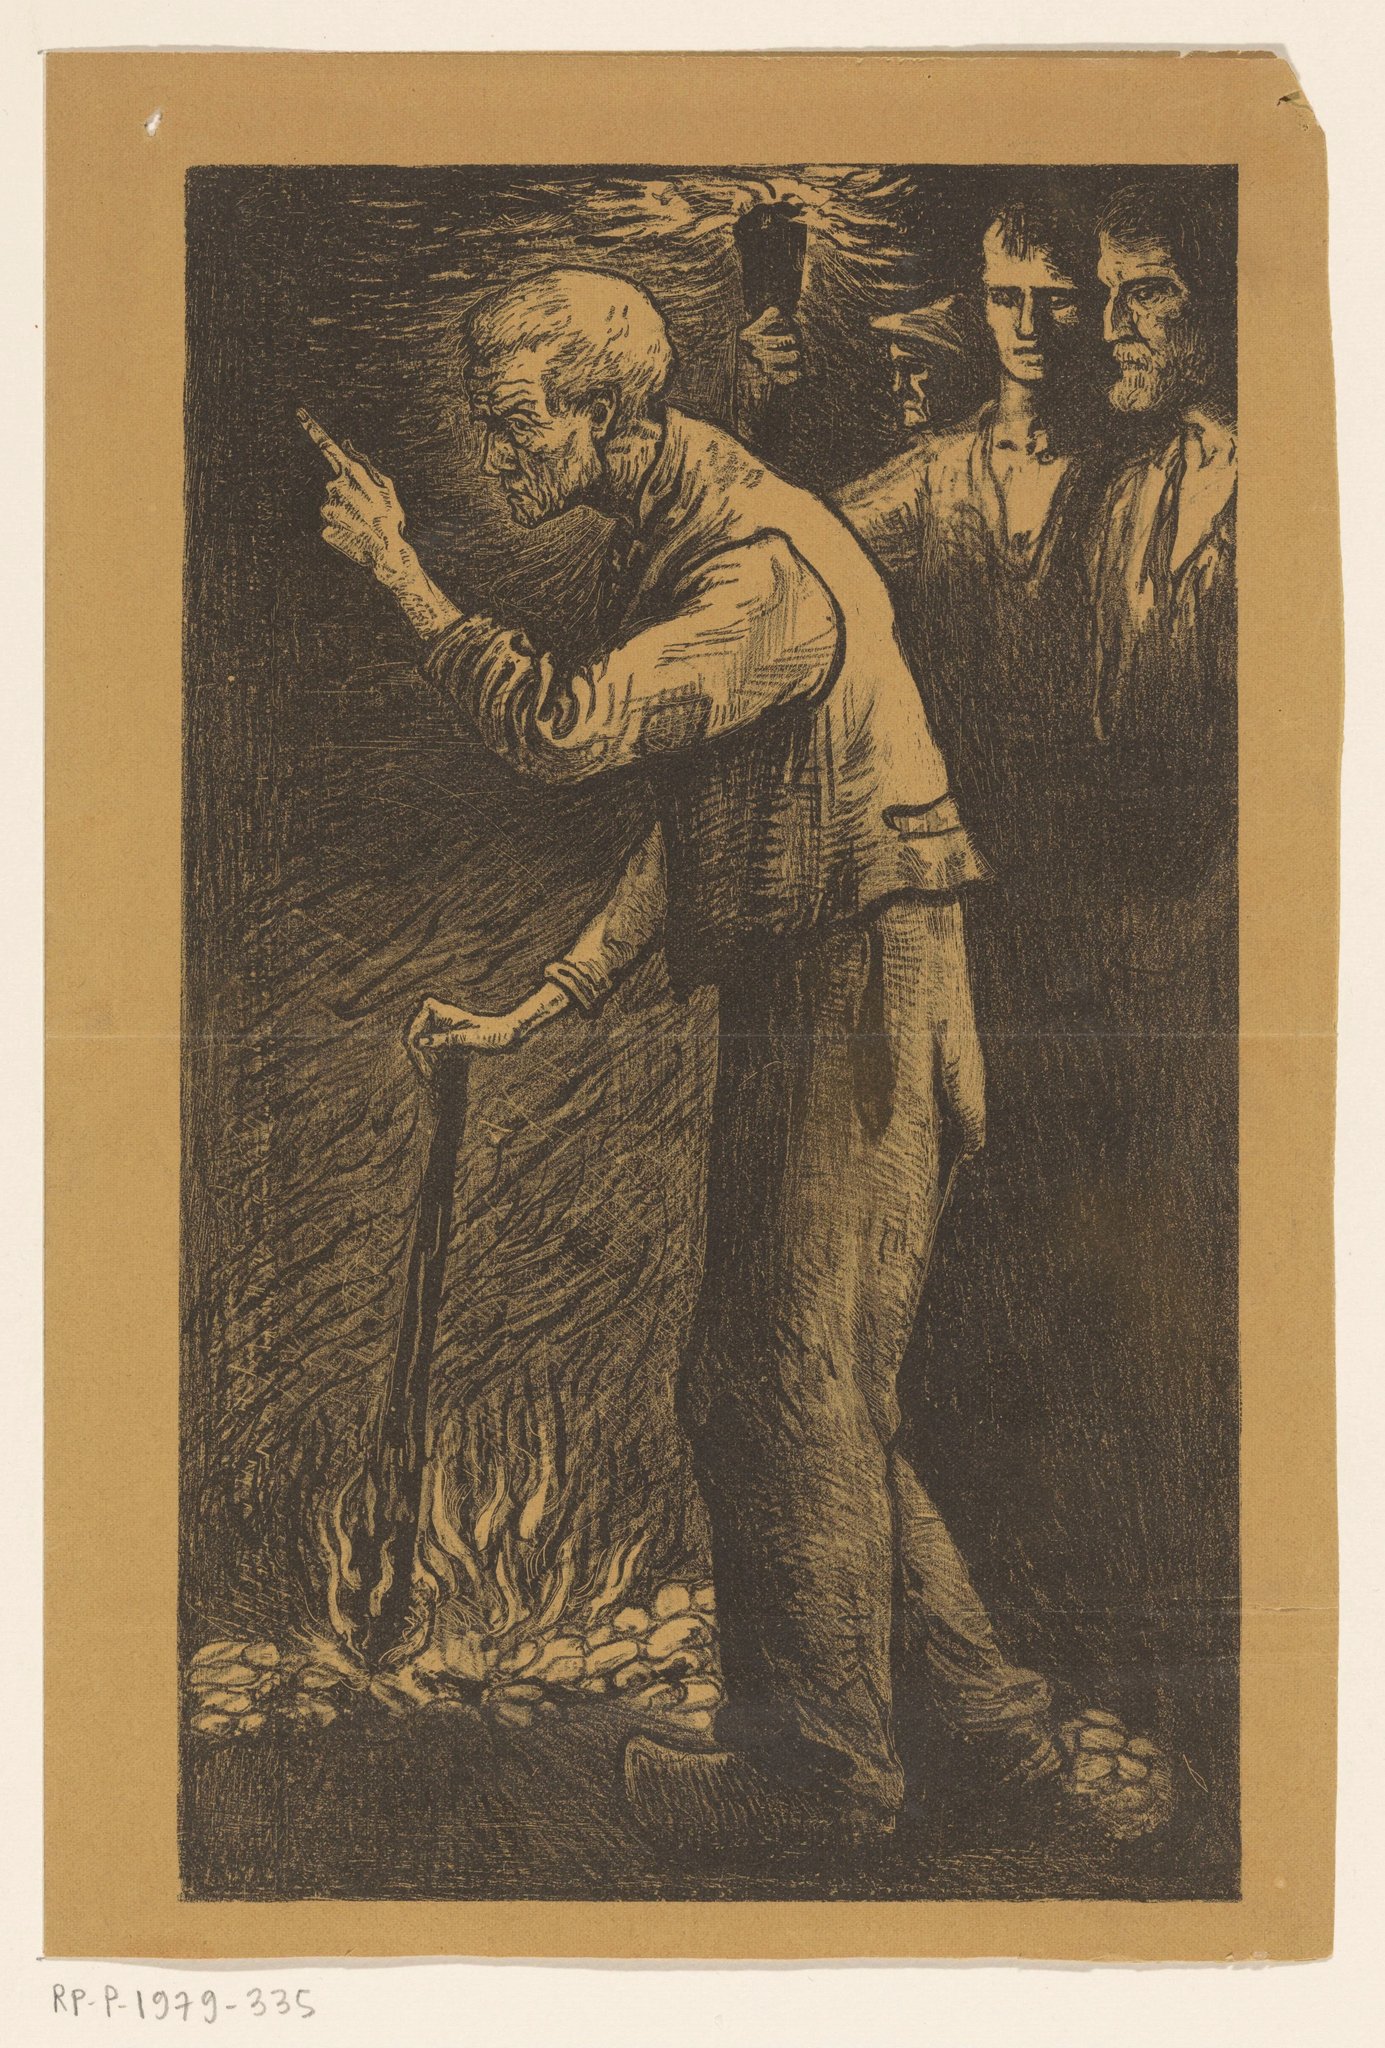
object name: print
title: De eerste eisch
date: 1898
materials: paper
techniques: lithograph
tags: torch, working class, labourers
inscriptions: collector's mark: Lugt 2228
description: Richard Roland Holst vervaardigde deze prent bij het gedicht 'De eerste eisch' van Henriëtte Roland Holst-van der Schalk, dat zij schreef 'ter herinnering aan de meeting voor Staatspensioneering, den Haag 19 Sept. '97.'